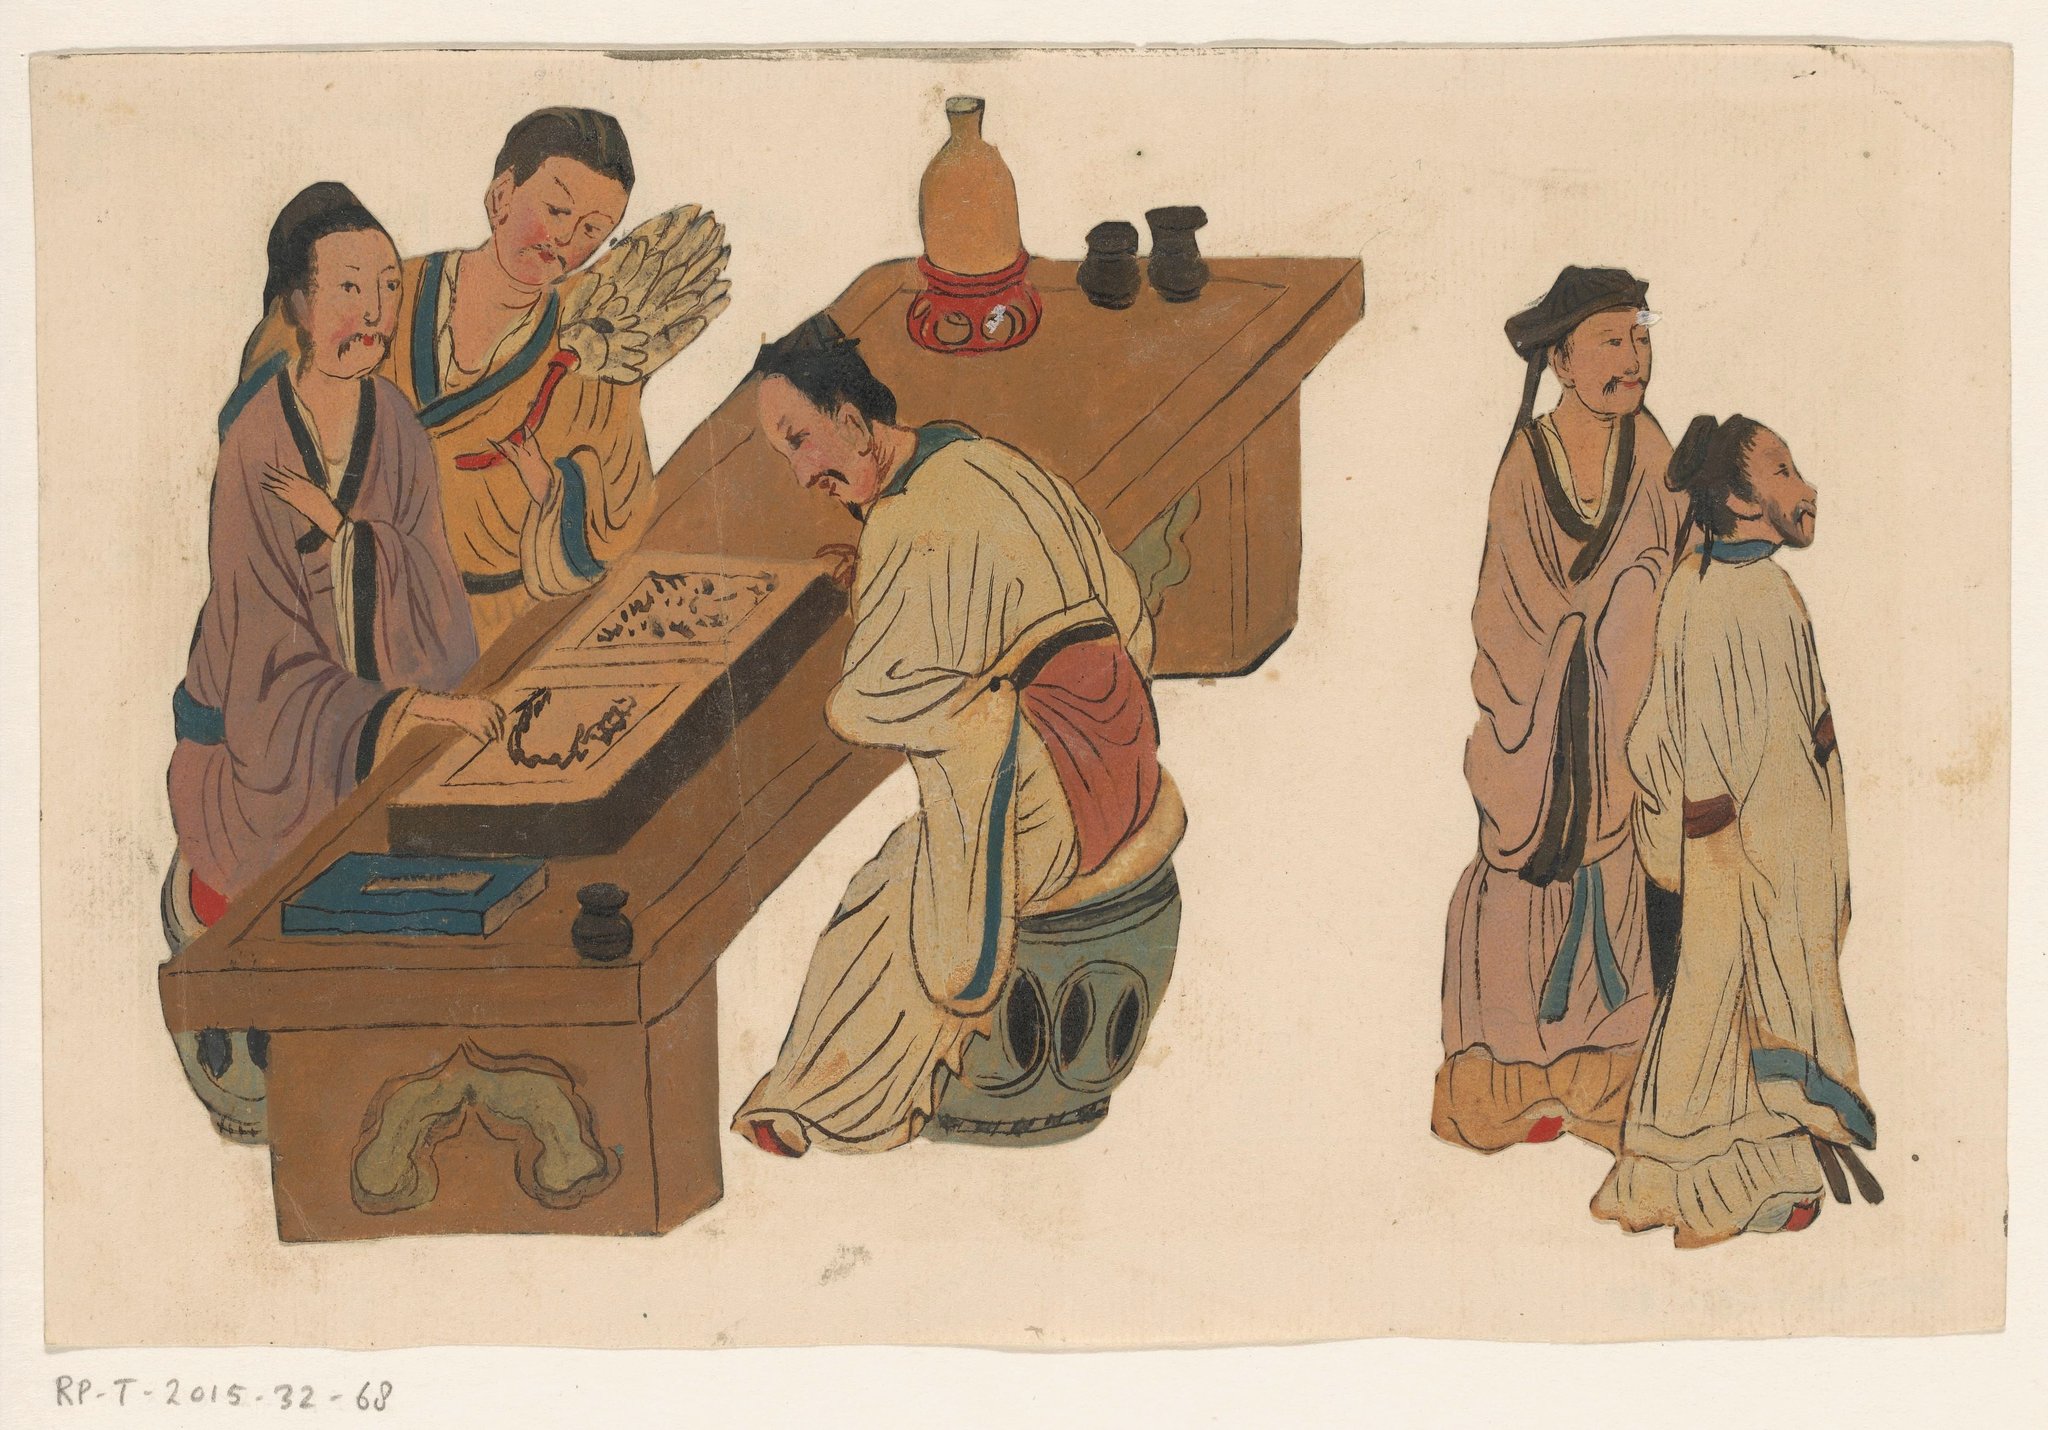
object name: drawing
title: Chinese boekverkoper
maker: Anonymous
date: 1800-1899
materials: paint, ink, paper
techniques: brush, pen, snipping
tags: chinese, book-shop, bookseller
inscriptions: watermark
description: Drie mannen rond een tafel met daarop een opengeslagen boek. Rechts twee mannen.